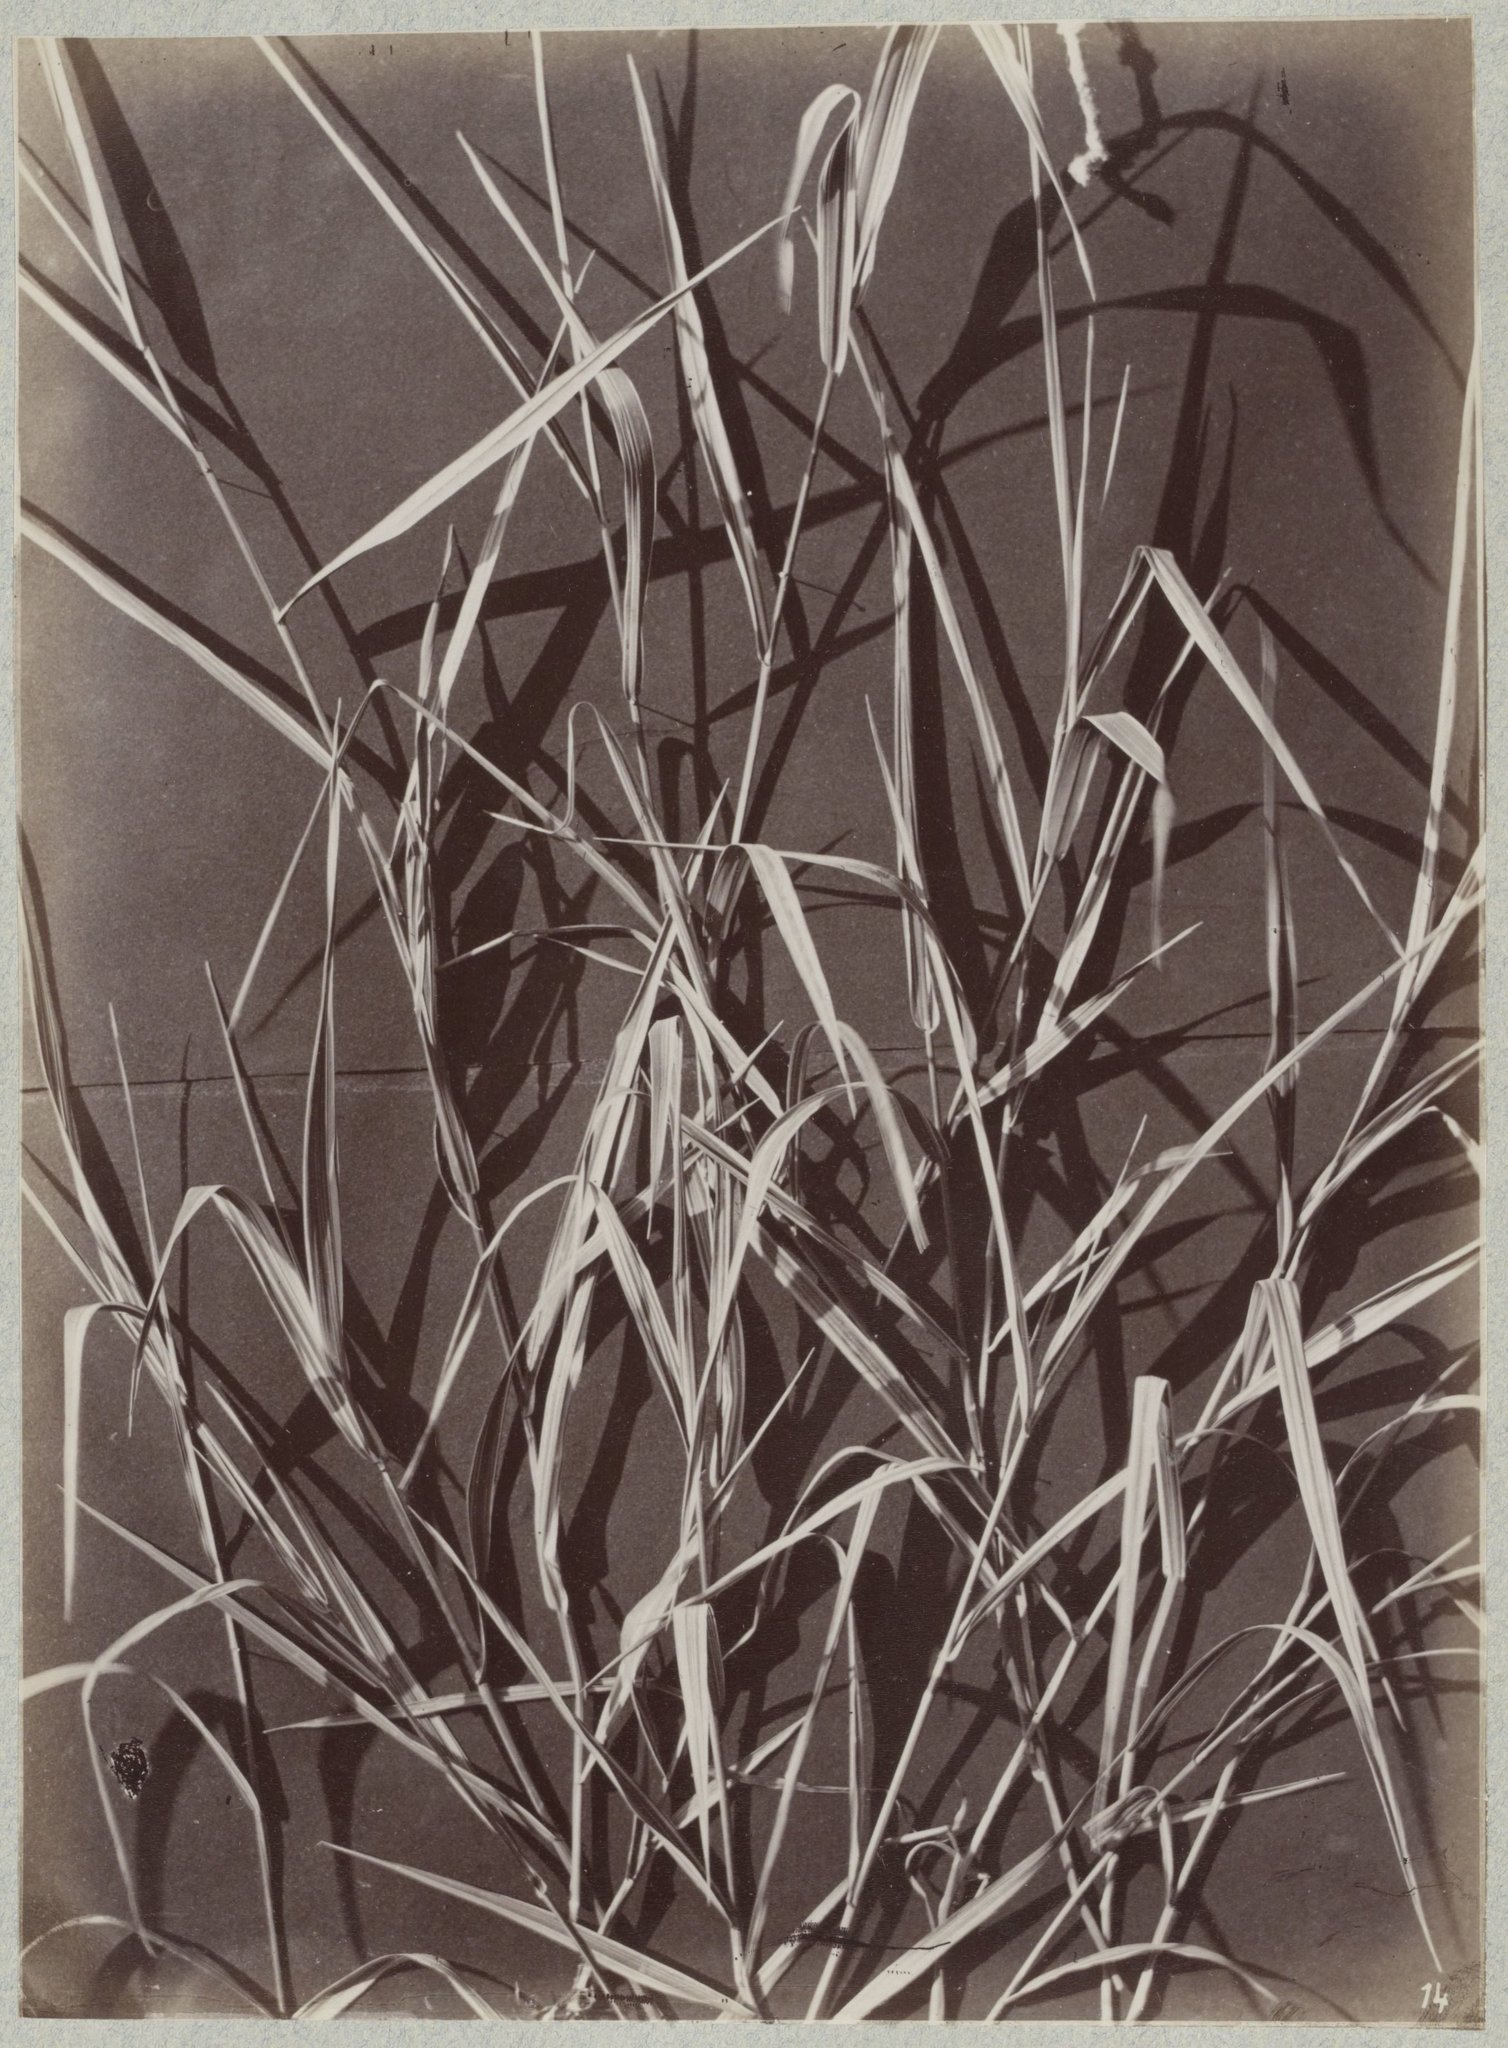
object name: photograph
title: Studies of Plants and Grasses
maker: a. calavas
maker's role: publisher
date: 1885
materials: cardboard, photographic support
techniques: albumen print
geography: paris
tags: plants; vegetation (+ branch, stick)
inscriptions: number: ‘14’, collector's mark: Lugt 3937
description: Because photographs were largely considered to be mere aids in the 19th century, the name of the photographer was generally not mentioned. The name on the mounts of these photographs is that of the publisher, the Paris firm of Calavas. From around 1875 it published vast amounts of photographs that were widely used as study material by artists.